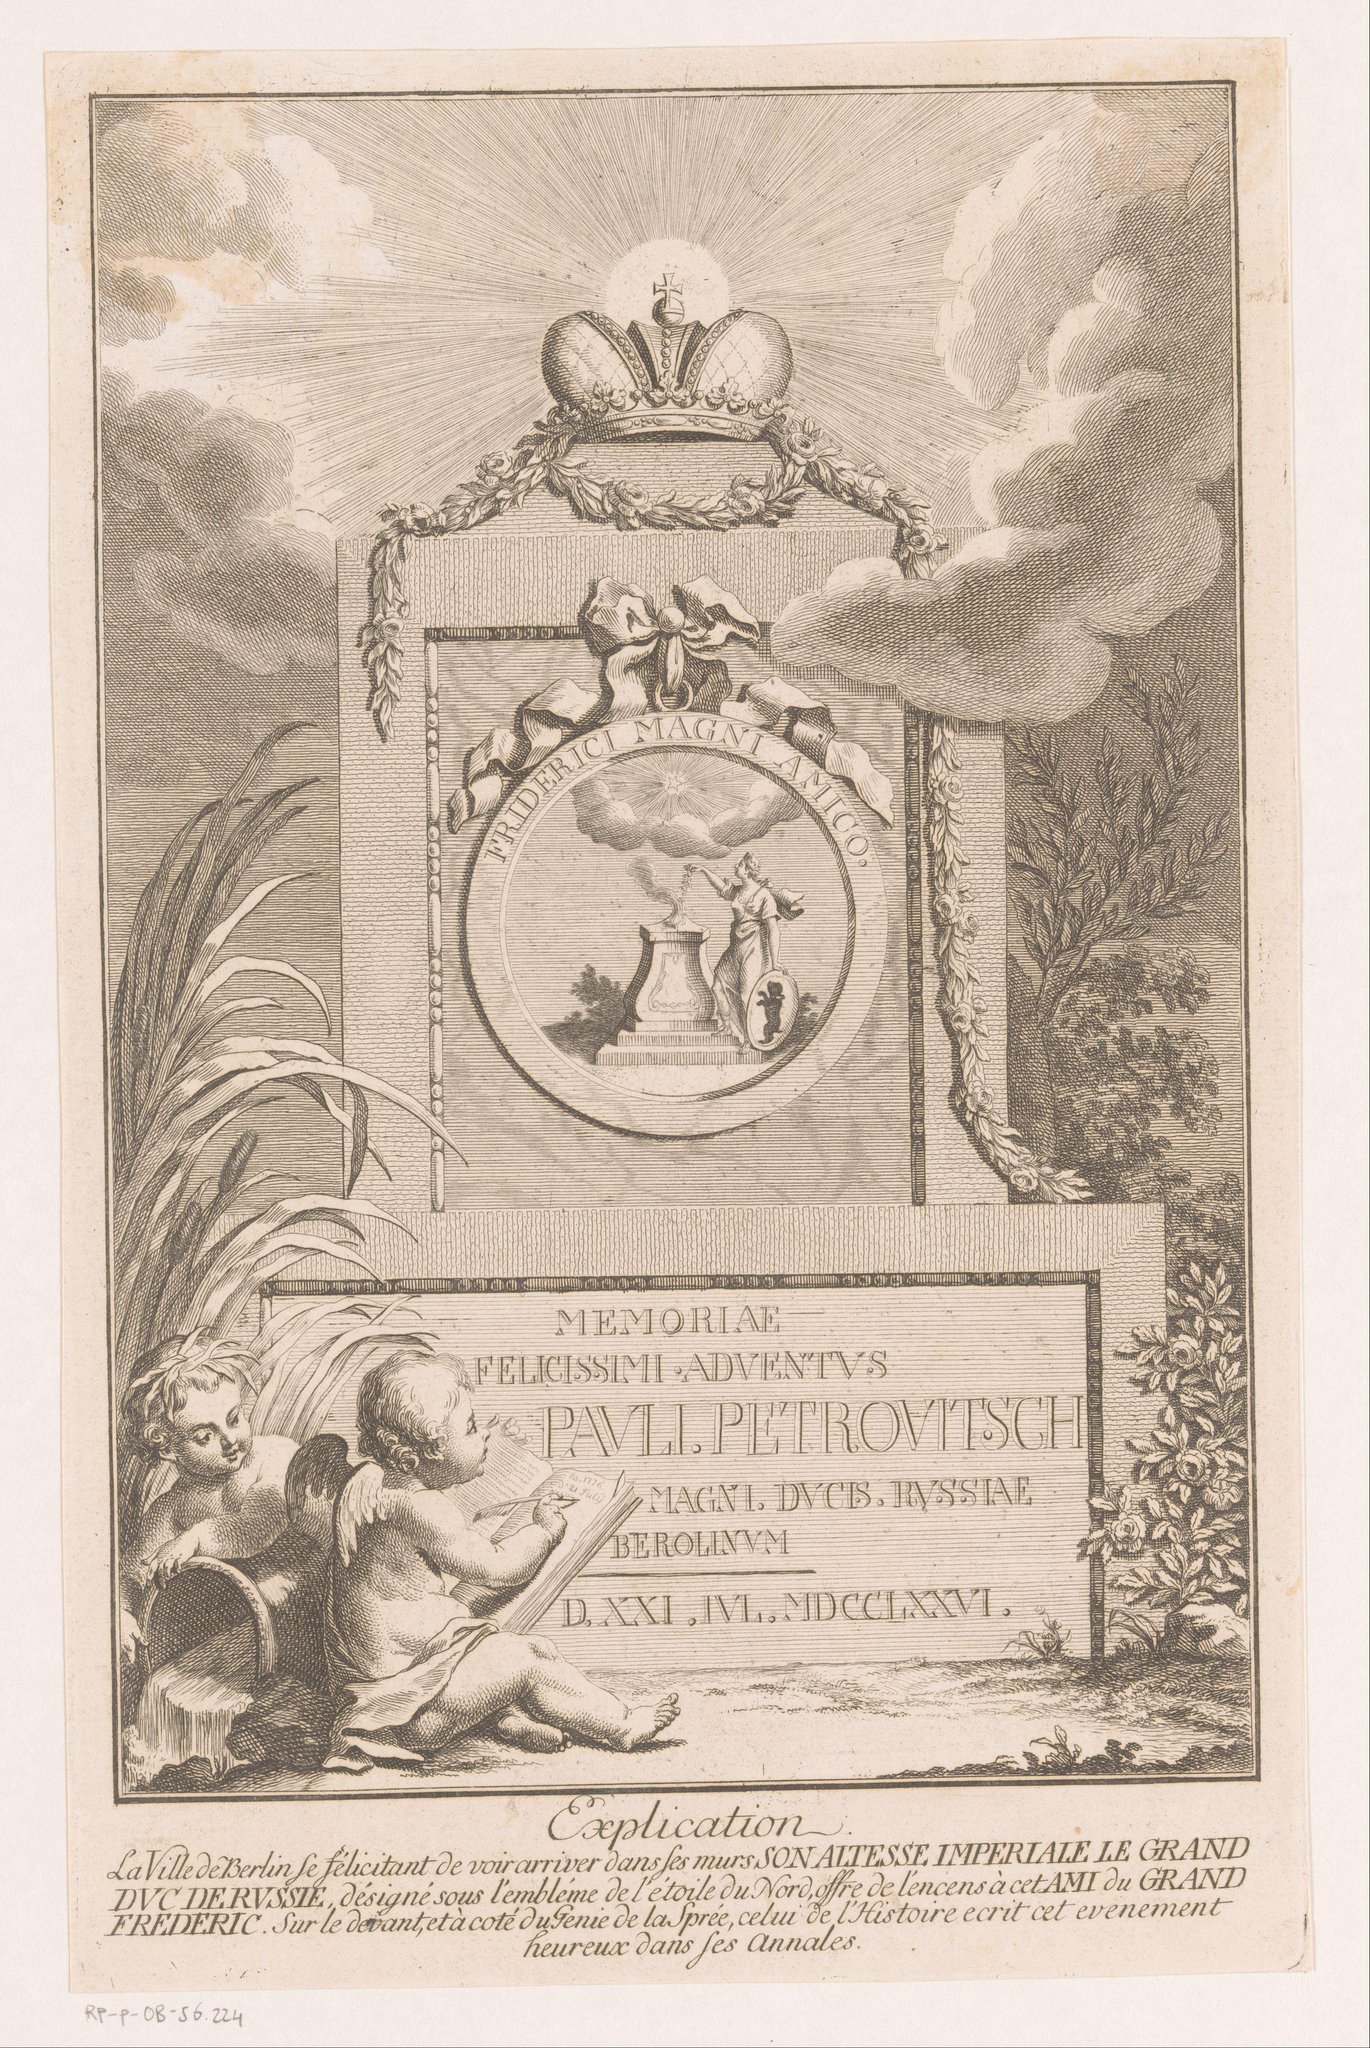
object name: print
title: Monument ter ere van de aankomst in Berlijn van Paul I, tsaar van Rusland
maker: ludwig wolf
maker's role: draughtsman, painter, print maker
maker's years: 1776-1832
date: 1786-1832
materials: paper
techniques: etching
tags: paul i (tsaar van rusland), river personified, 'fiumi' (ripa), monument, statue, cupids: 'amores', 'amoretti', 'putti'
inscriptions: collector's mark: Lugt 2228